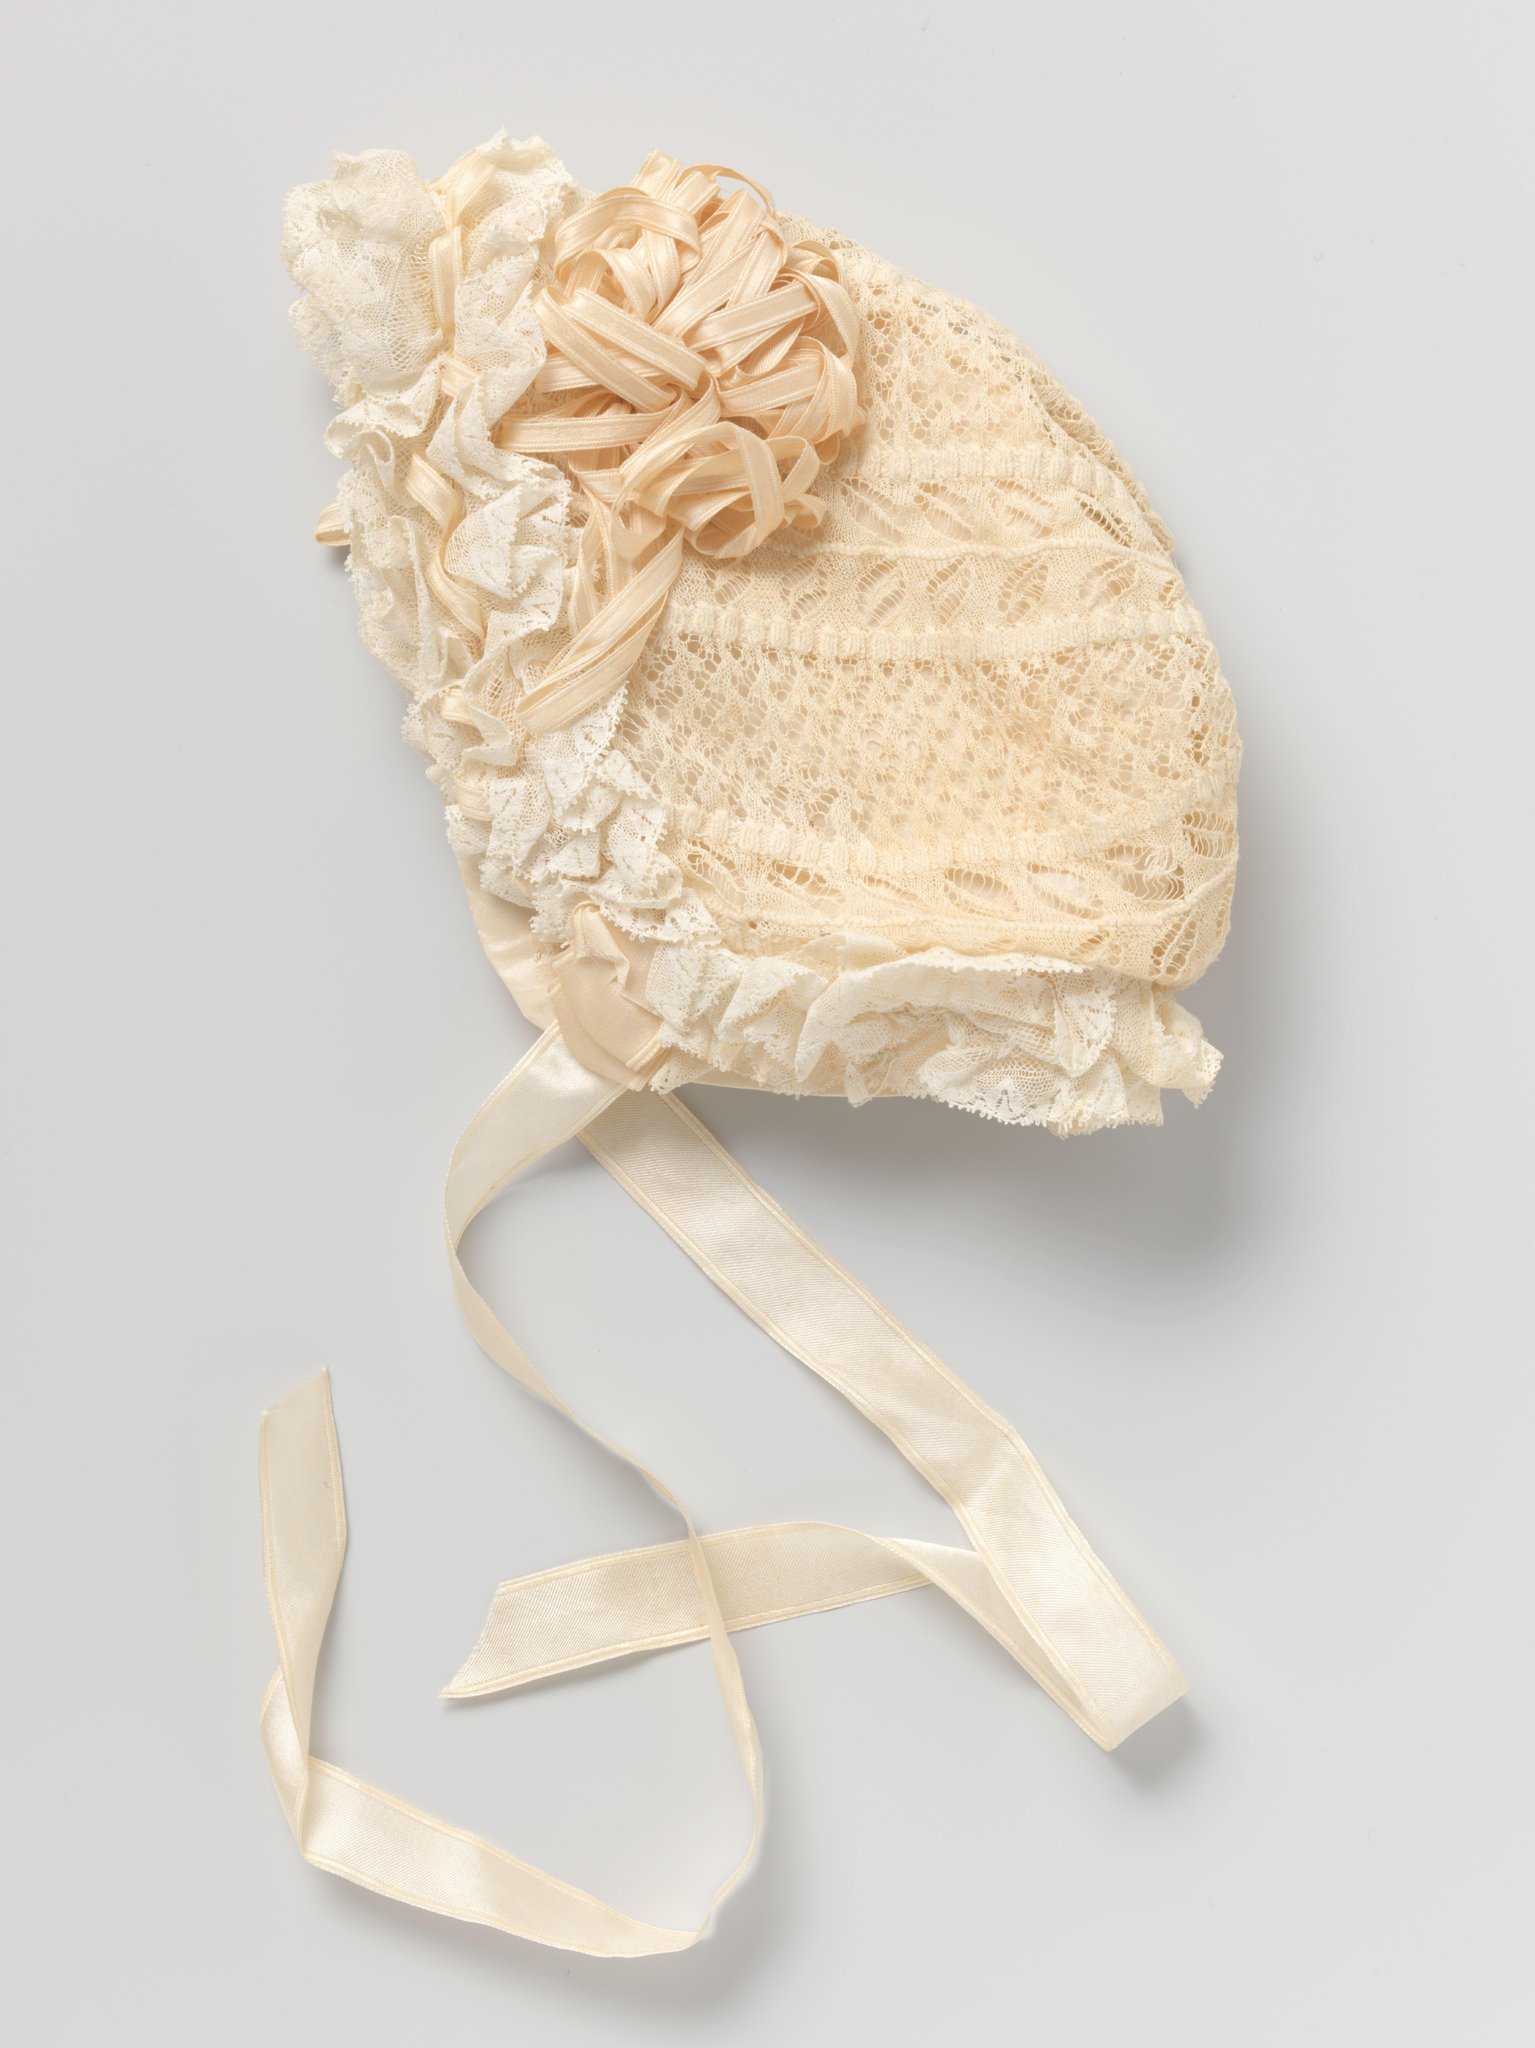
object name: cap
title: Kindermuts van ajour gebreide crèmekleurige katoen, versierd met lussen en twee rozetten van smal, crèmekleurig satijnband.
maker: Anonymous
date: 1800-1899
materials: cotton, textile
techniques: knitting, weave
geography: netherlands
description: Kindermuts van fijne gebreide katoen. Patroon van strepen met blaadjes, afgewisseld door strepen met zigzagwerk. Strookjes machinale kant. Rozetjes van vergeelde lintjes.